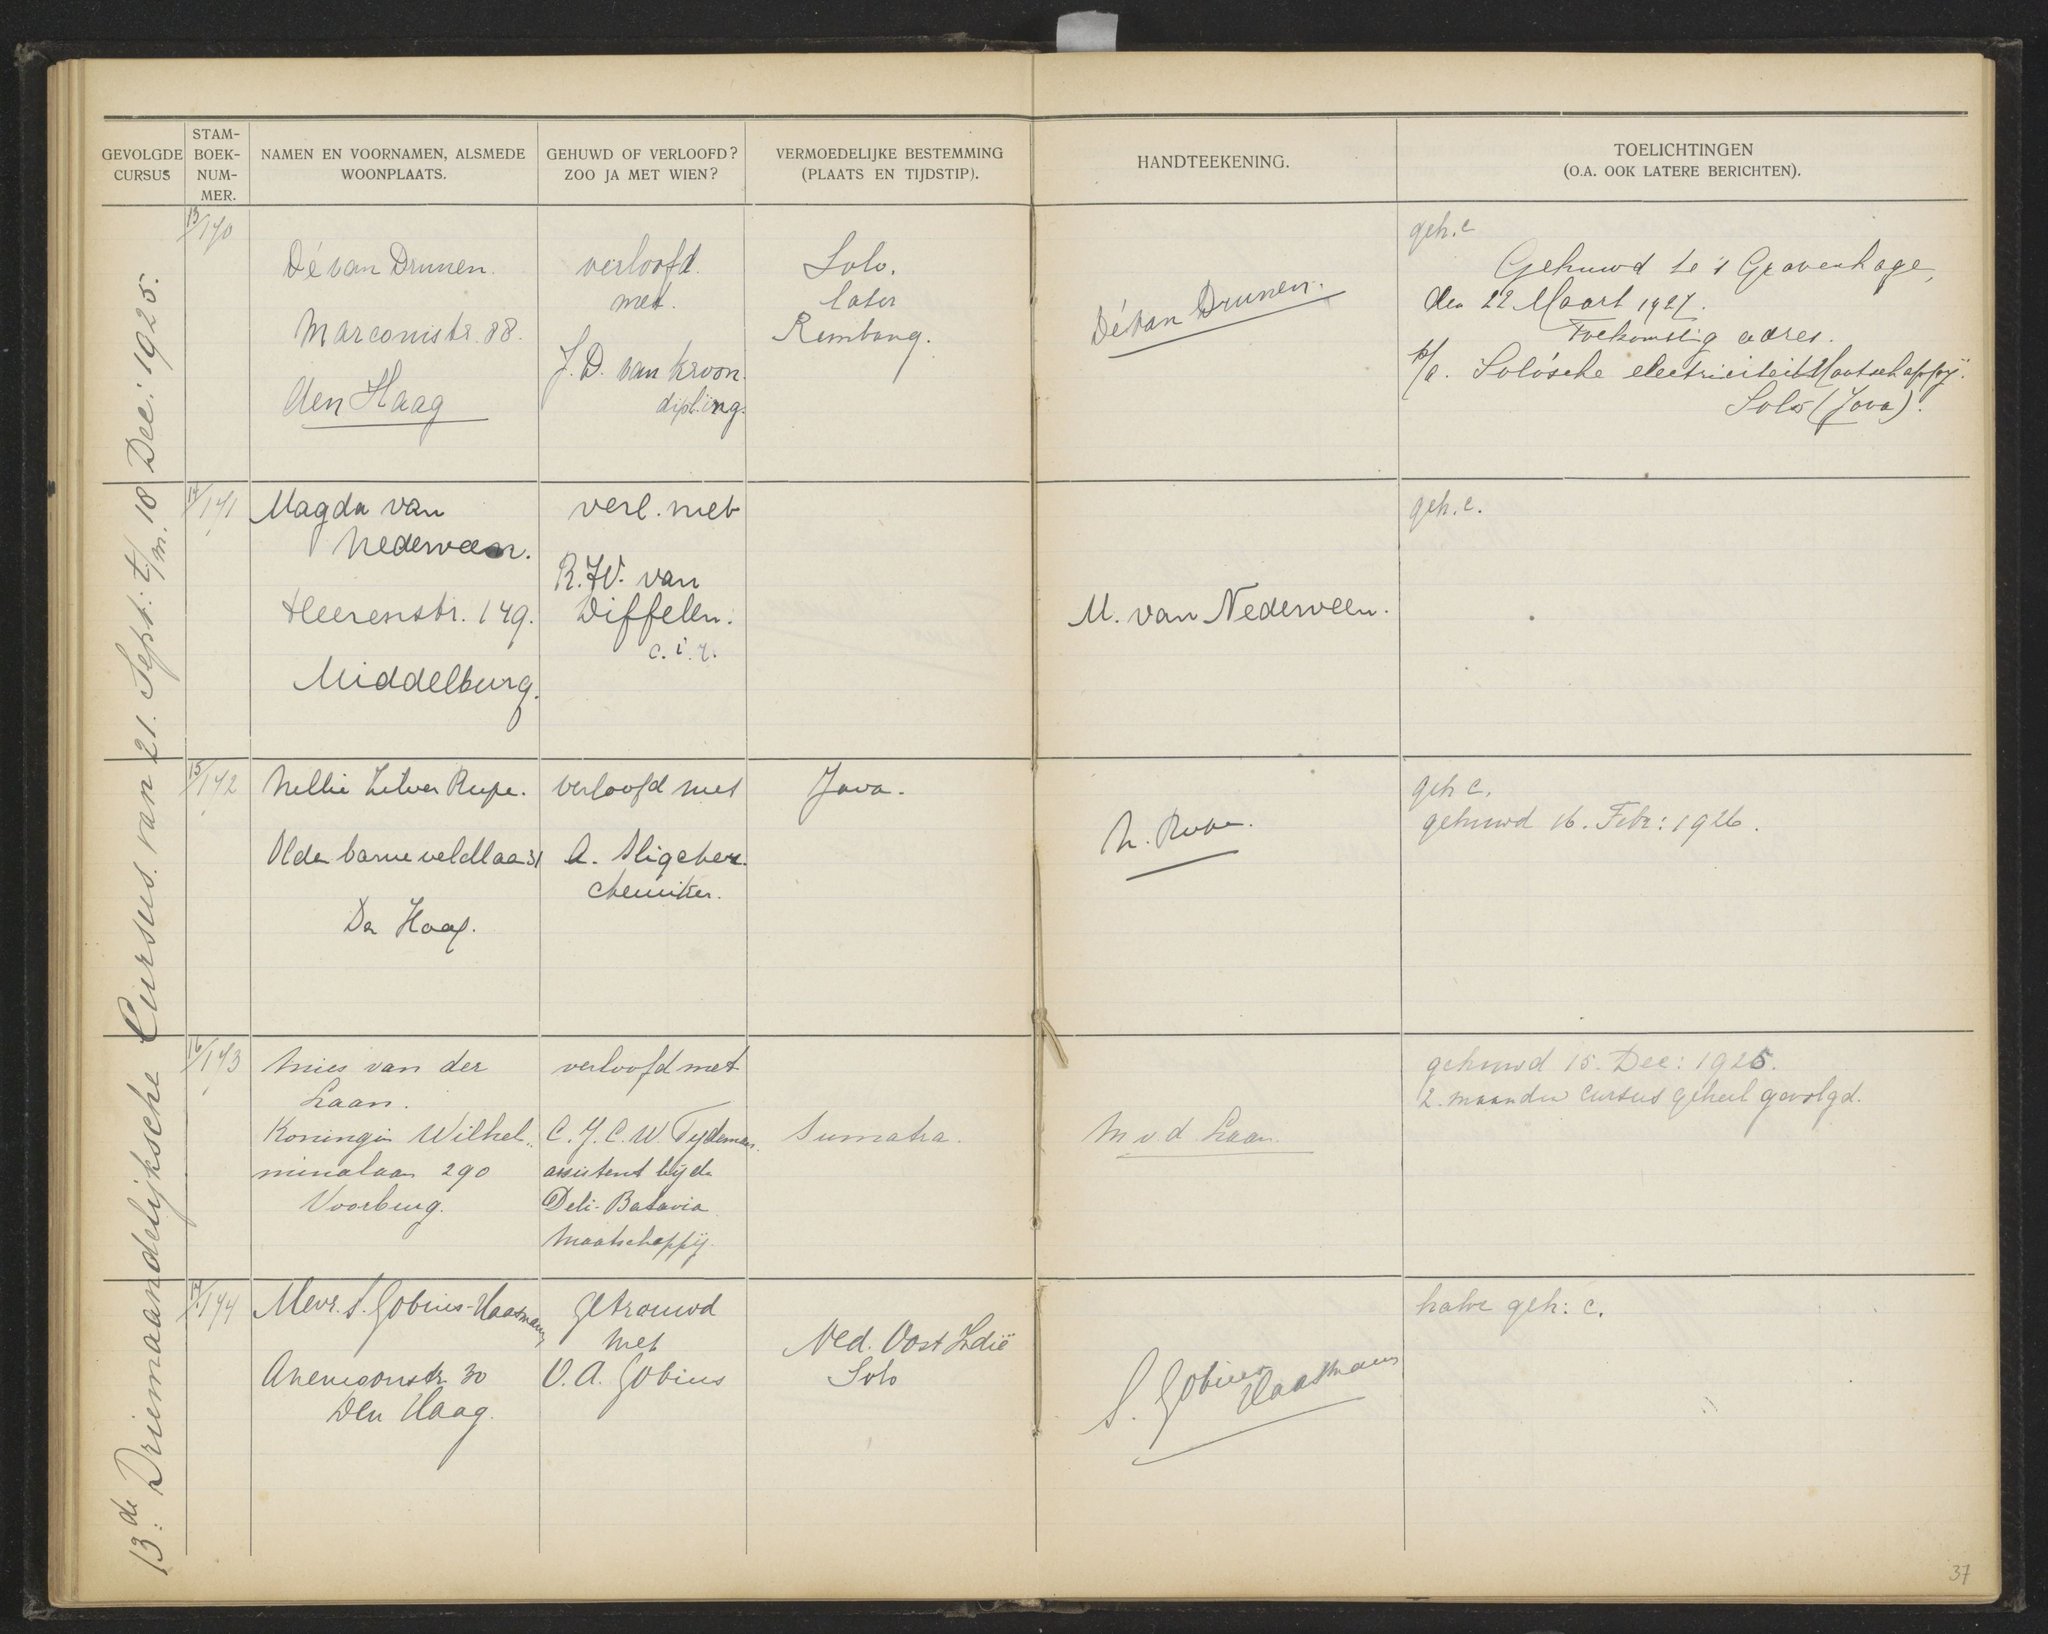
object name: album leaf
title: Blad 37 uit Stamboek van de leerlingen der Koloniale School voor Meisjes en Vrouwen te 's-Gravenhage deel I (1921-1929)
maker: Anonymous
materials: paper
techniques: printing, writing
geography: the hague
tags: further education (+ pupil), further education, the hague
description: Twee pagina's met gegevens van de deelnemers aan de 13e driemaandelijkse cursus van 21 september tot en met 18 december 1925, stamboeknummers 170 tot en met 174. Onderdeel van Stamboek van de leerlingen der Koloniale School voor Meisjes en Vrouwen te 's-Gravenhage deel I (1921-1929).